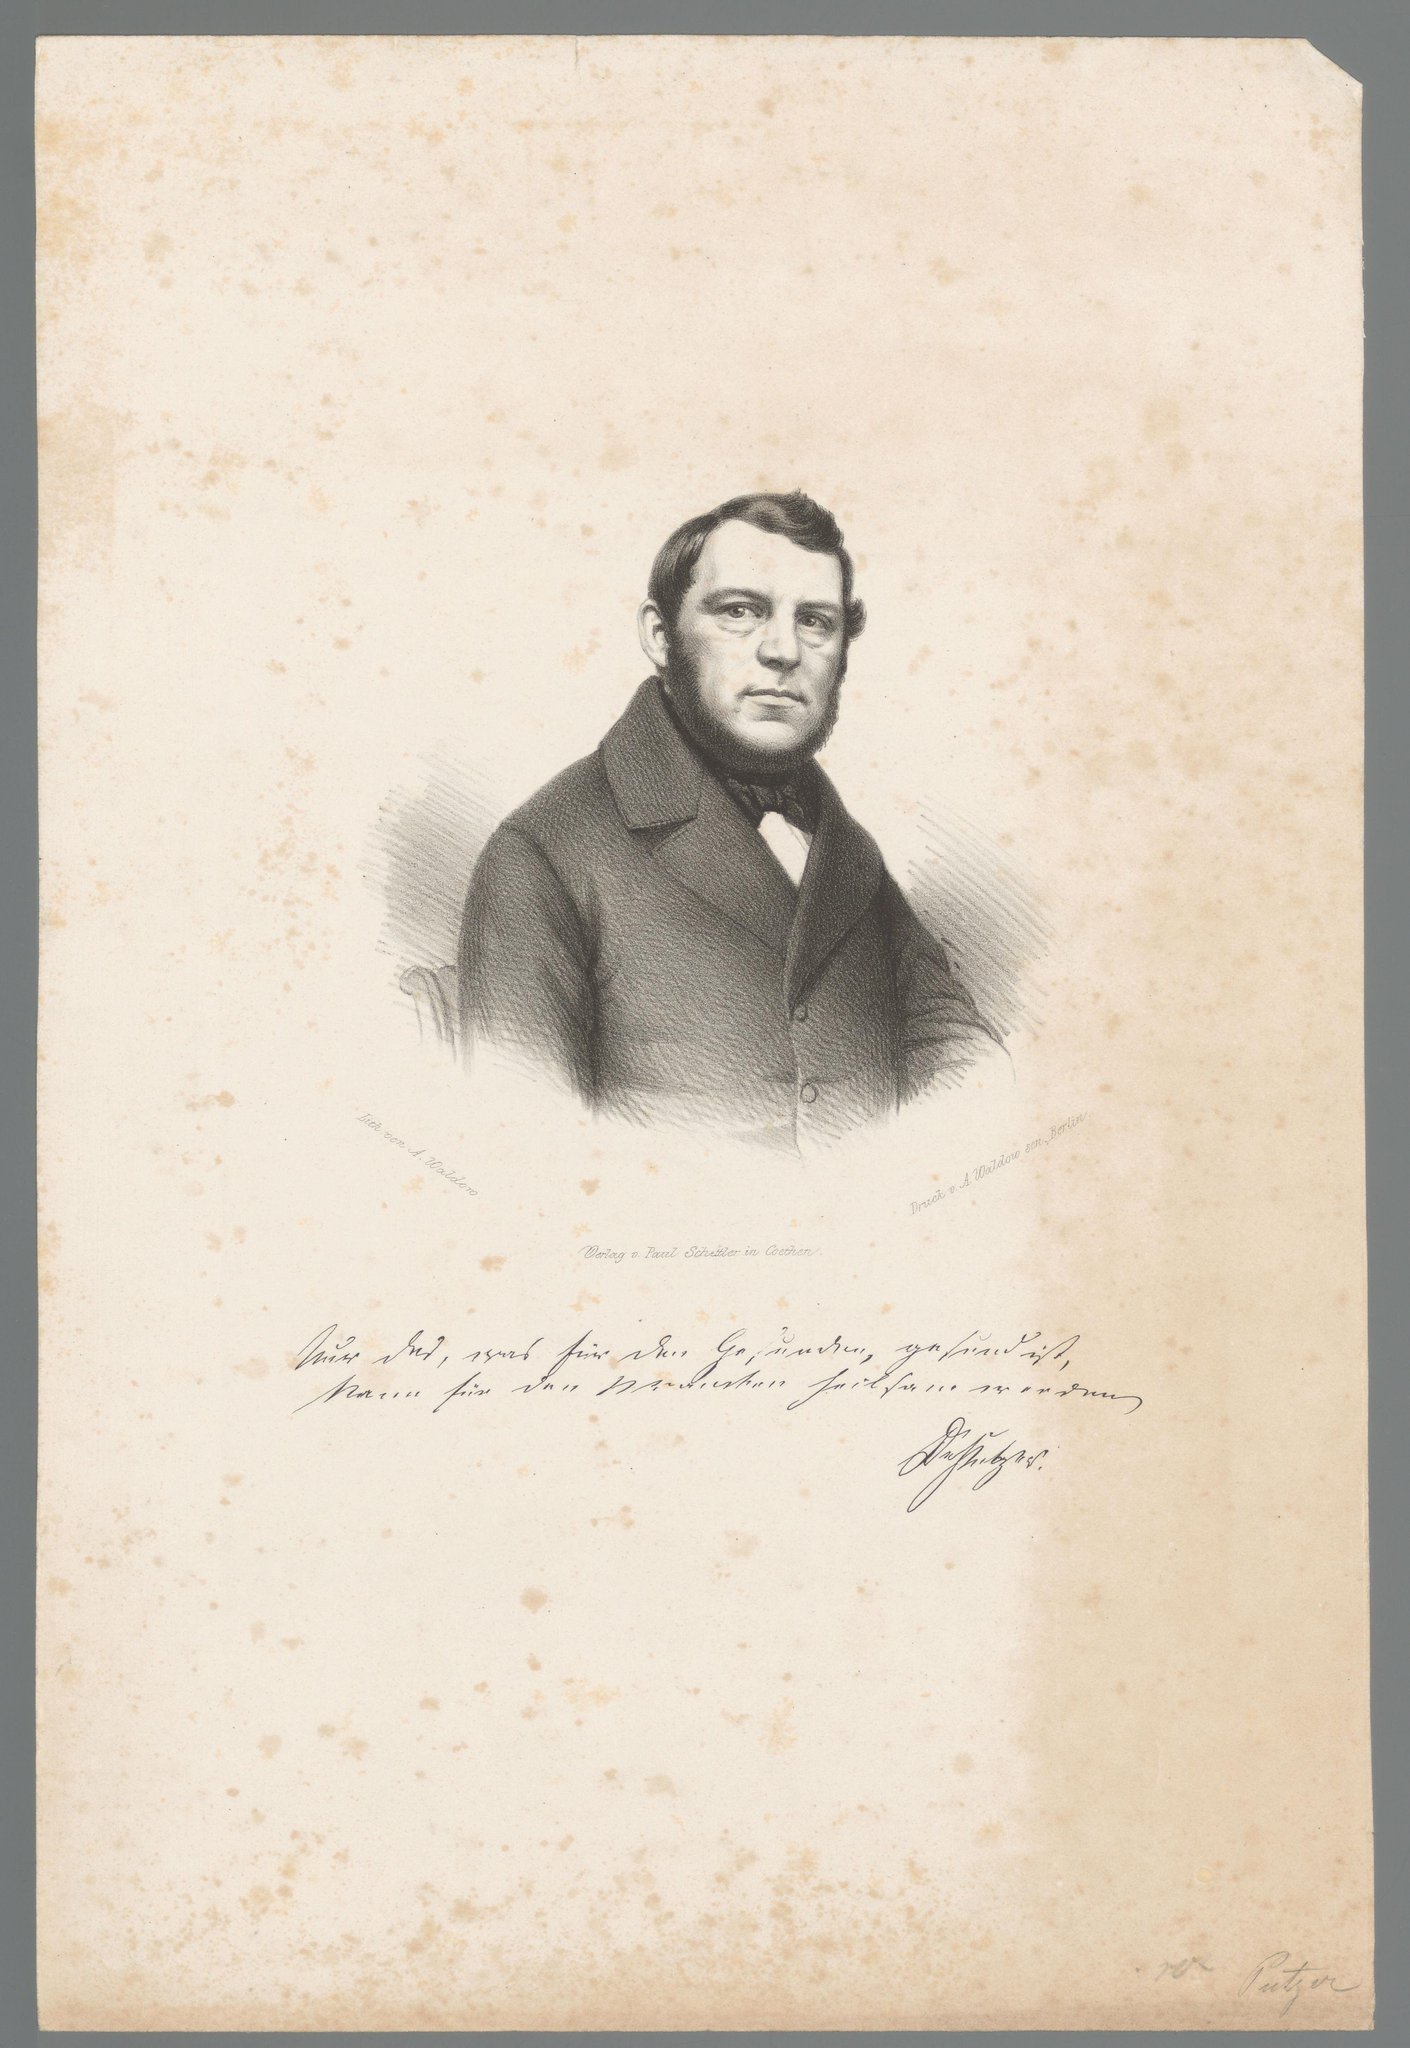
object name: print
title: Portret van een onbekende man, mogelijk Putzer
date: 1820-1870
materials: paper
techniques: lithograph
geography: berlin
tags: adult man, historical persons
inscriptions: collector's mark: Lugt 2228